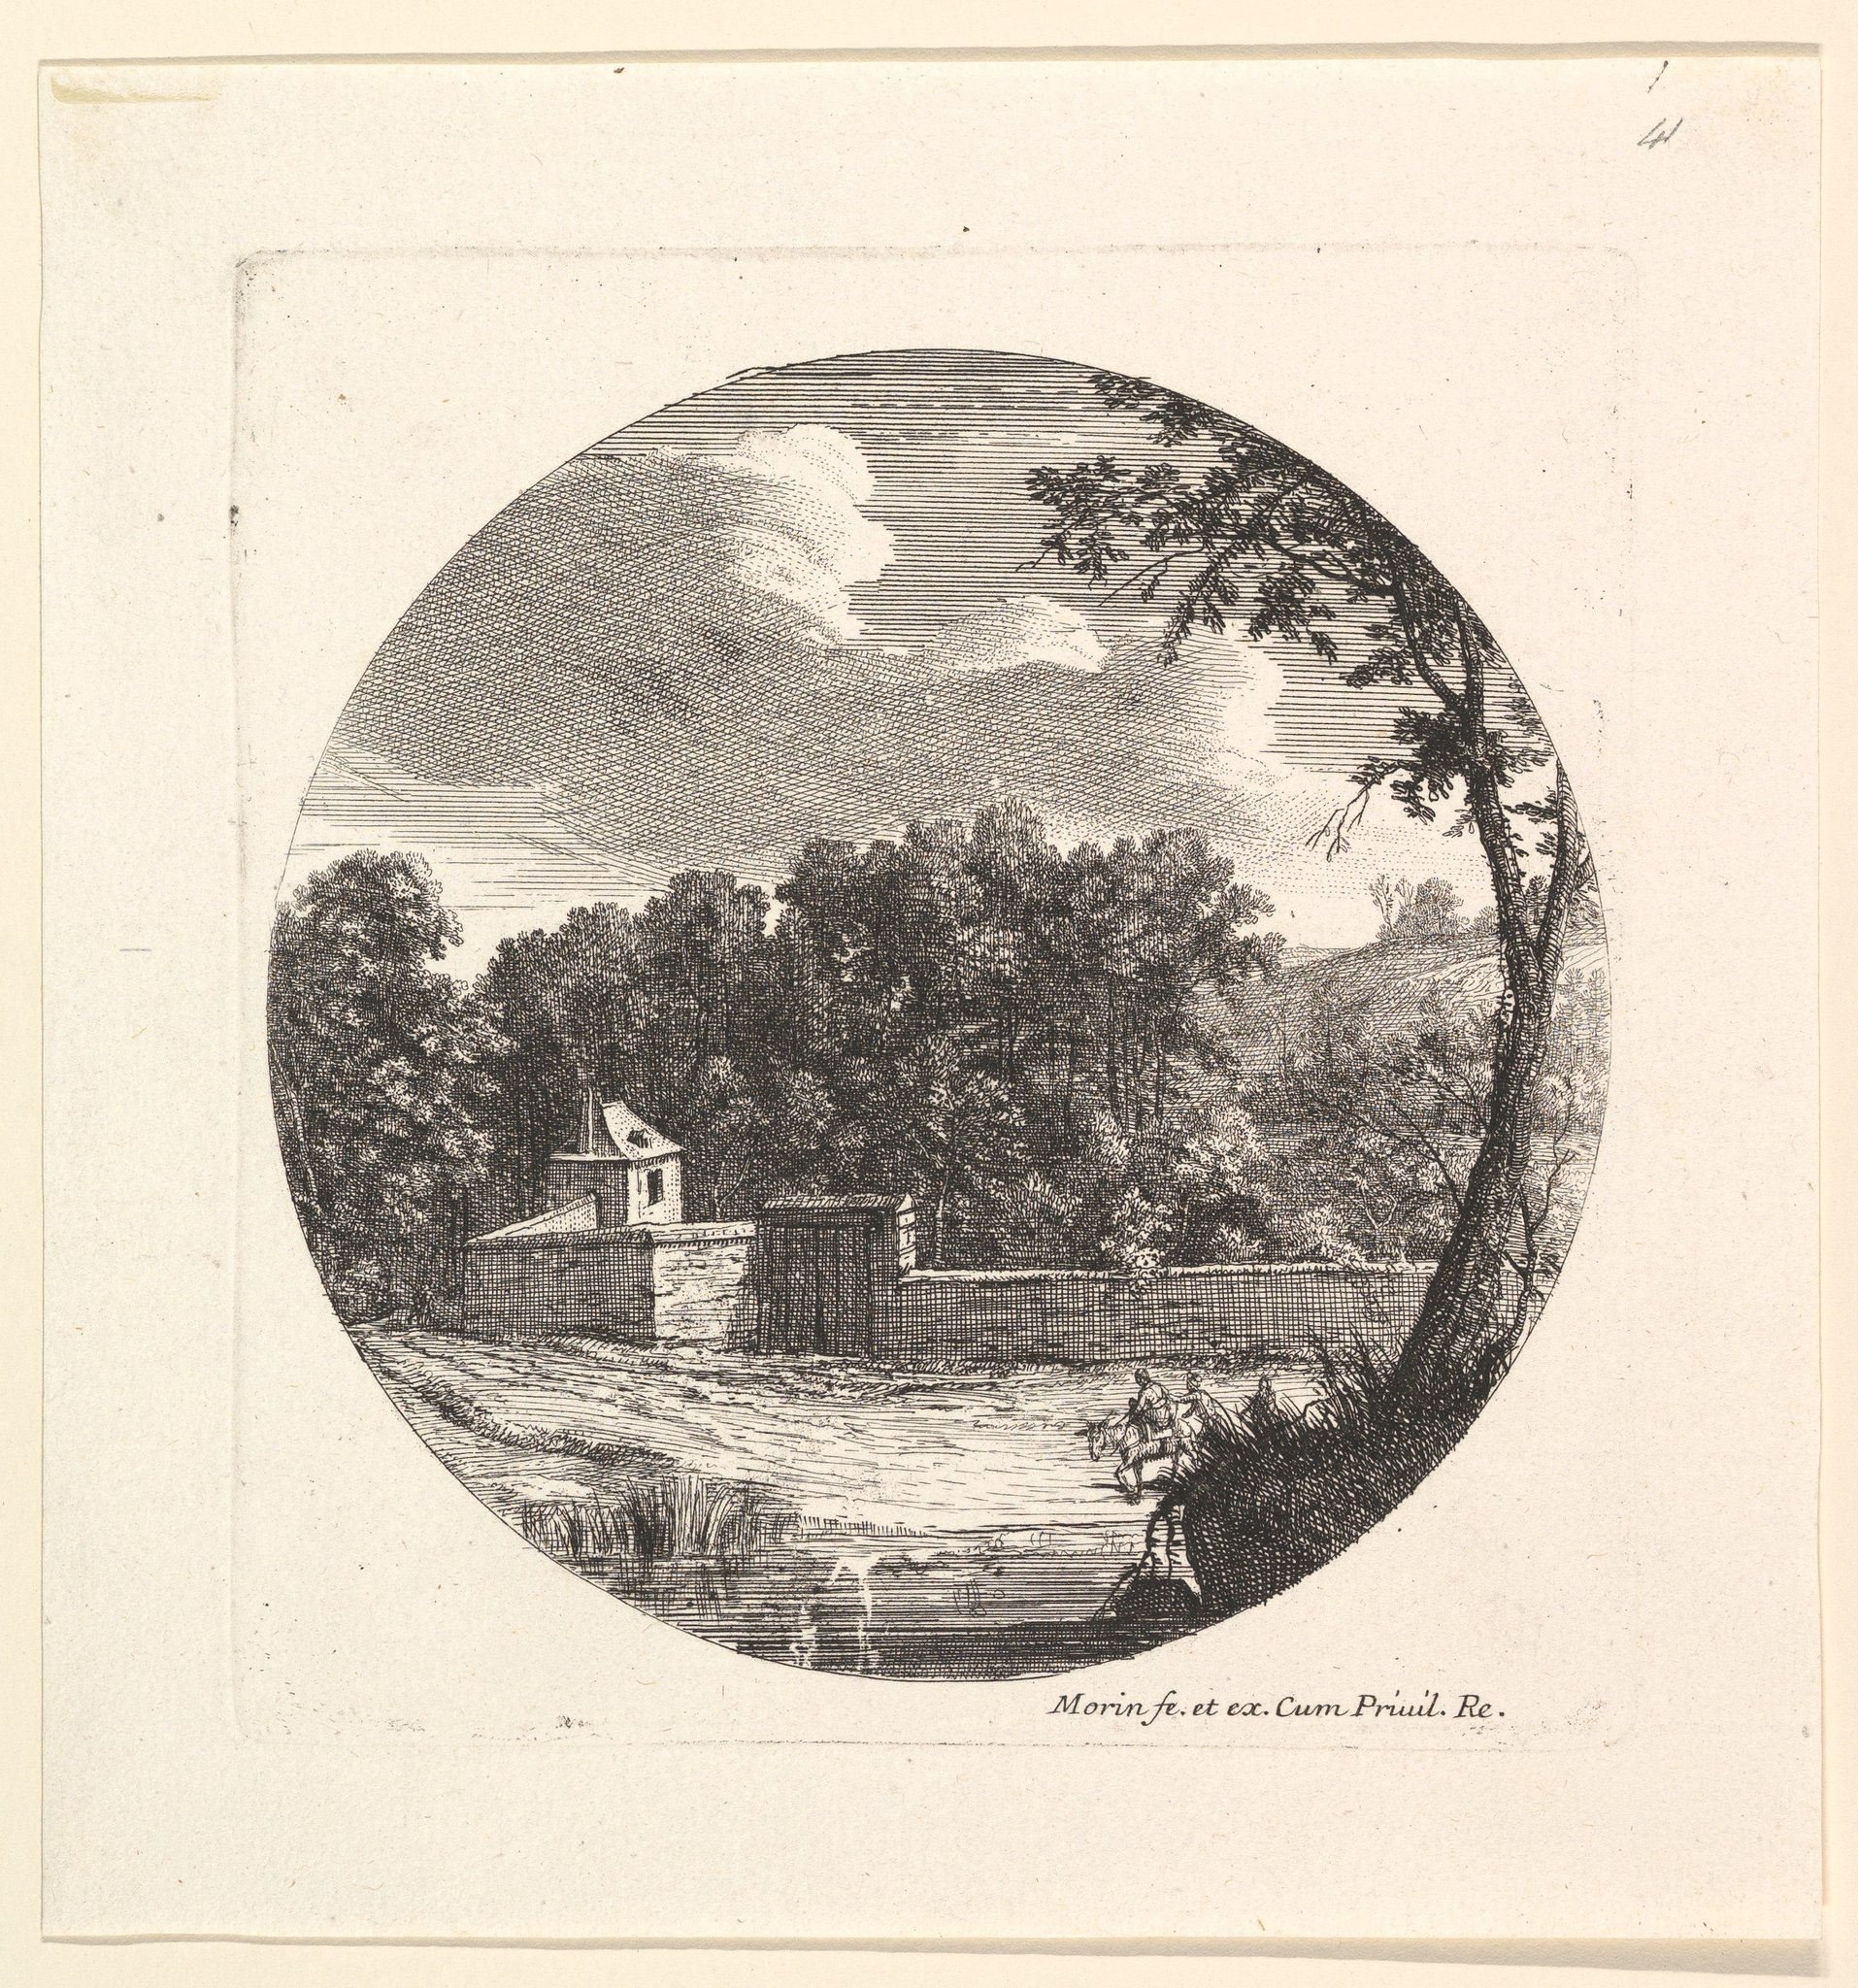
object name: print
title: Le Porte Balle assis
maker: jean morin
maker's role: artist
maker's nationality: french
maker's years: 1605-1650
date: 1605-1650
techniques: etching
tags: buildings,trees